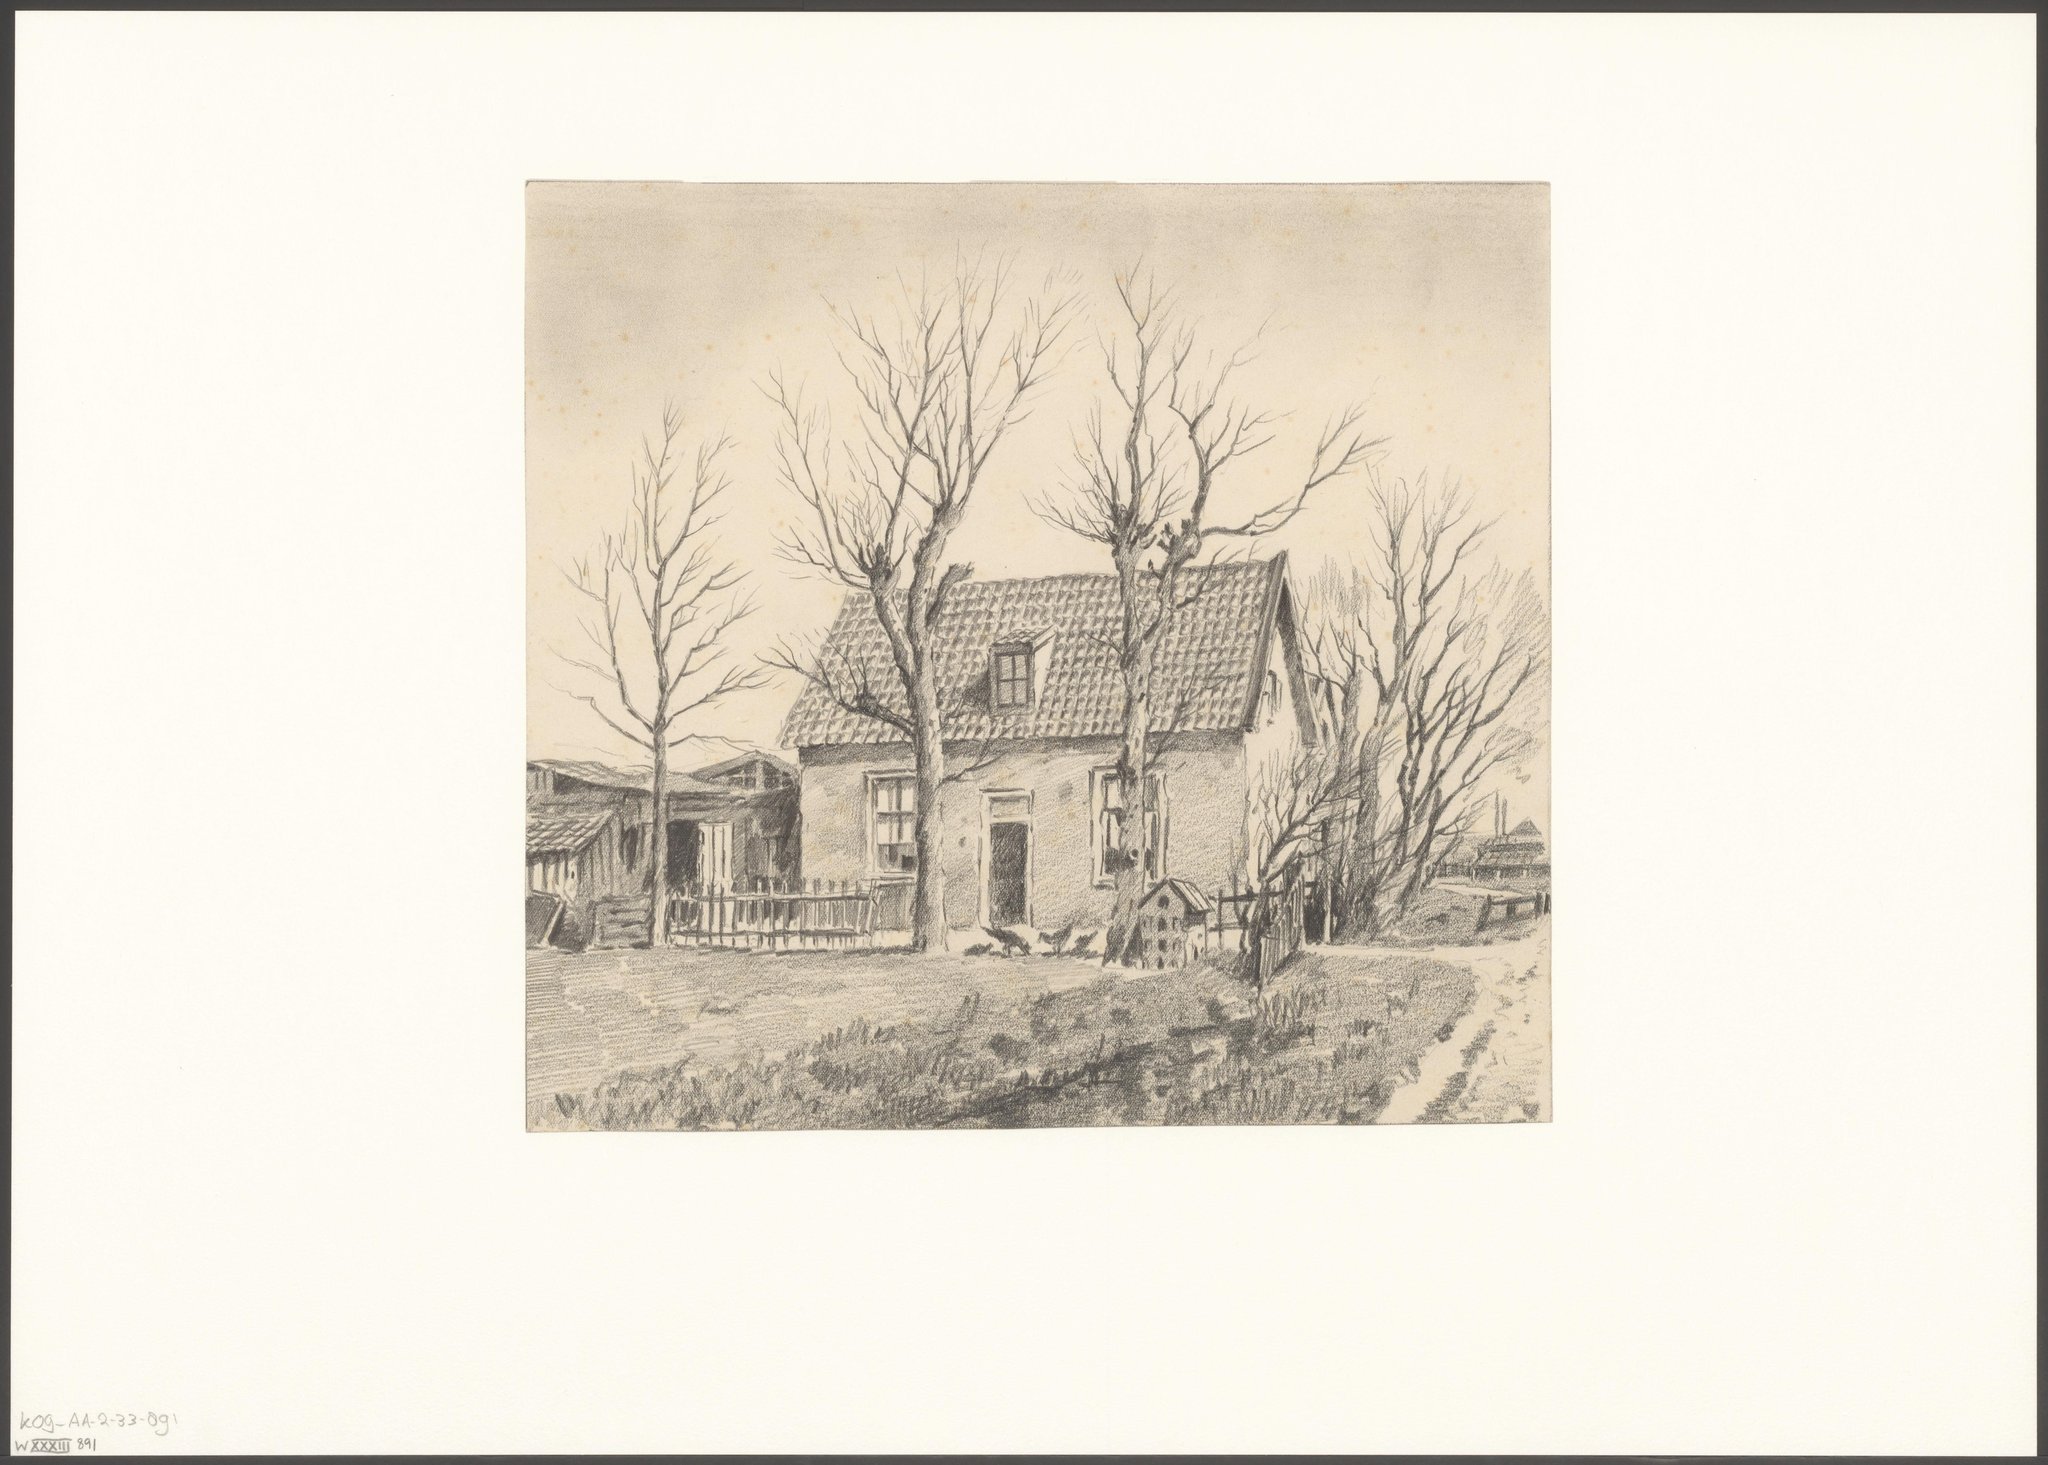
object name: drawing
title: Gezicht op een huis bij de Ringdijk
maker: tinus de jongh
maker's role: print maker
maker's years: 1885-1942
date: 1919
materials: chalk, paper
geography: amsterdam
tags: city-view in general; 'veduta', road, path, the usual house or row of houses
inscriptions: collector's mark: Lugt 800a, signature and date: ‘TinusdeJongh 1919’, inscription: ‘Gezicht op het (...) ruim 95 jaar’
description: Tekening binnen de Atlas Van Eck ingedeeld op wijknummer 33.